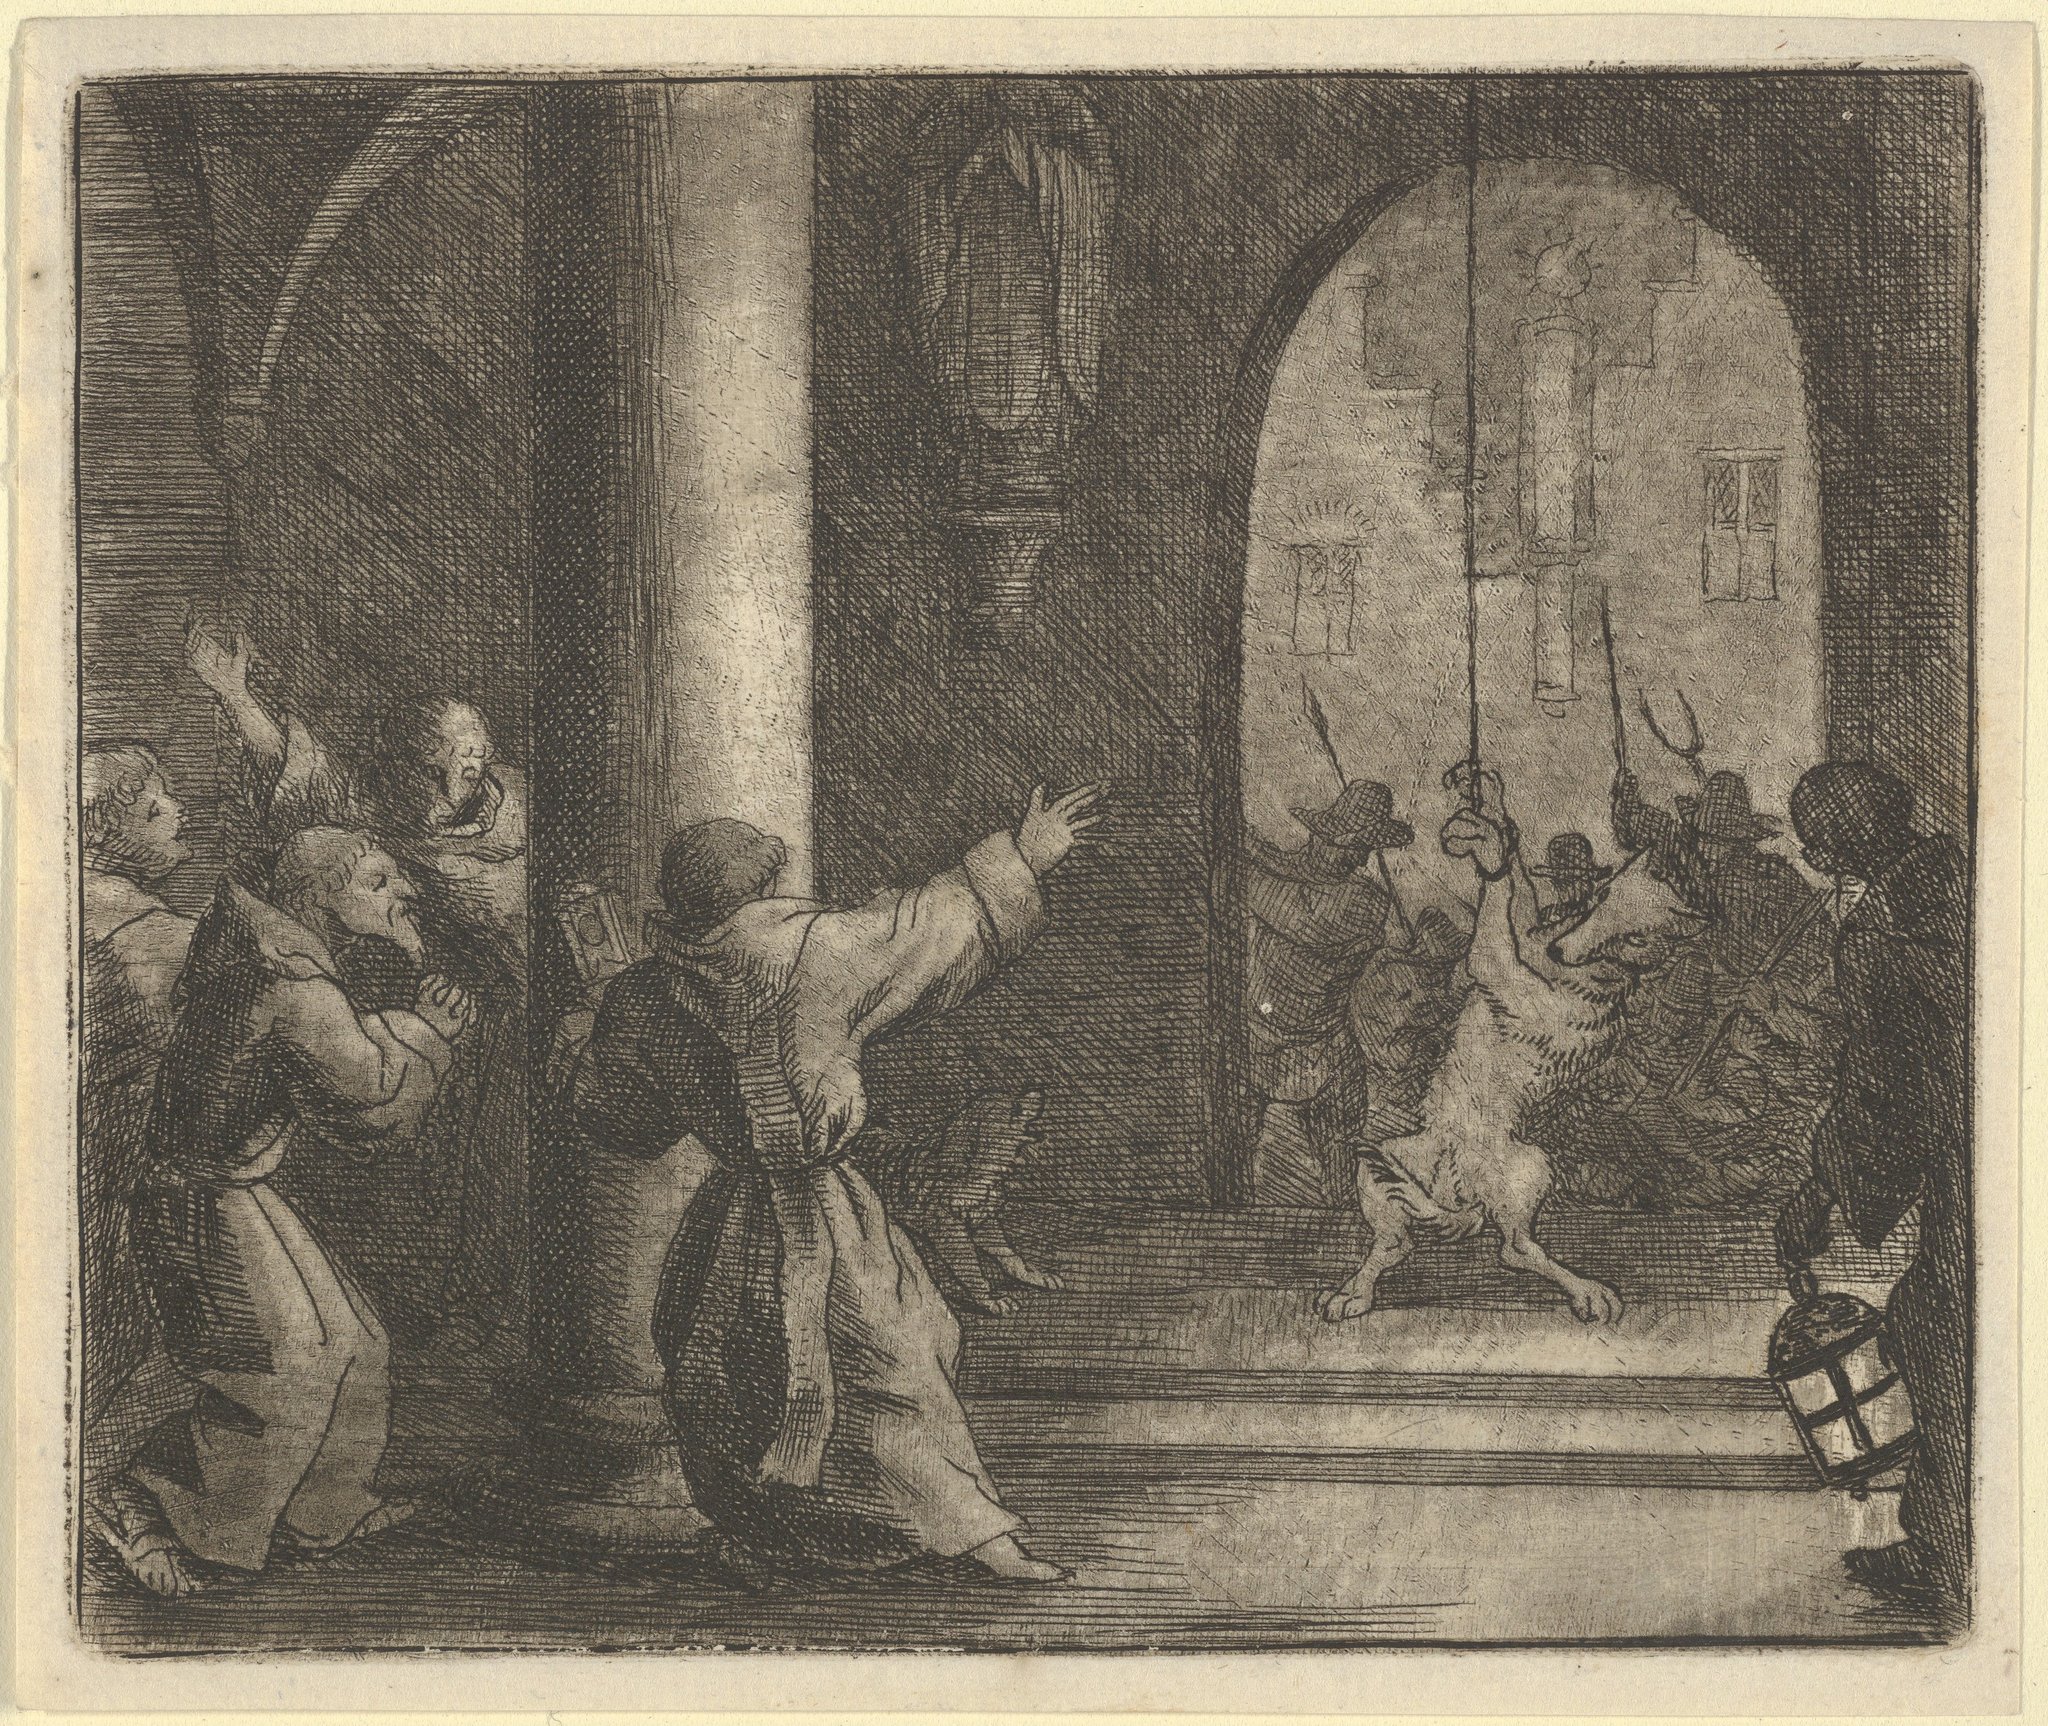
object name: print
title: The Wolf Rings the Bells of a Convent from Hendrick van Alcmar's Renard The Fox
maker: allart van everdingen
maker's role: artist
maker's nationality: dutch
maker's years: 1621-1675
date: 1650-1675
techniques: engraving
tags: animals,men,monks